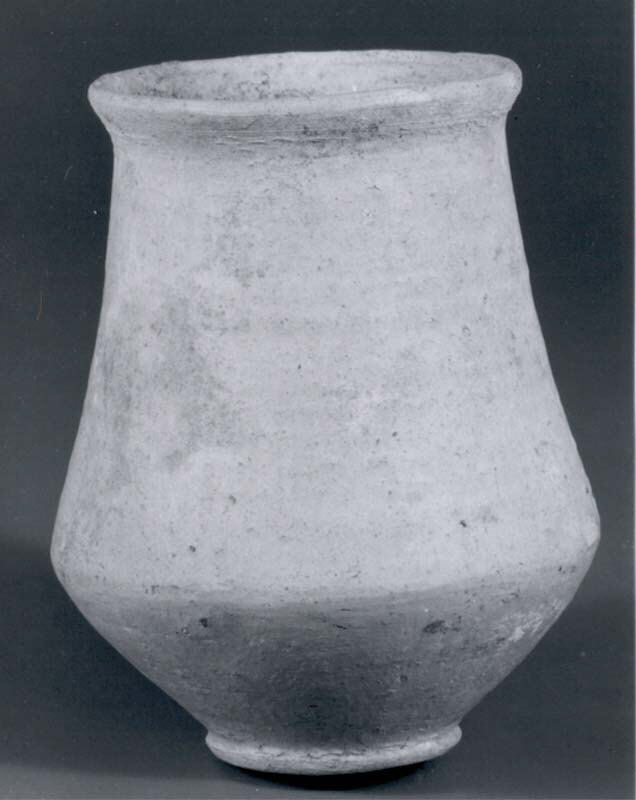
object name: cup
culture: iranian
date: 1900-1501 BCE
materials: ceramic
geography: iran